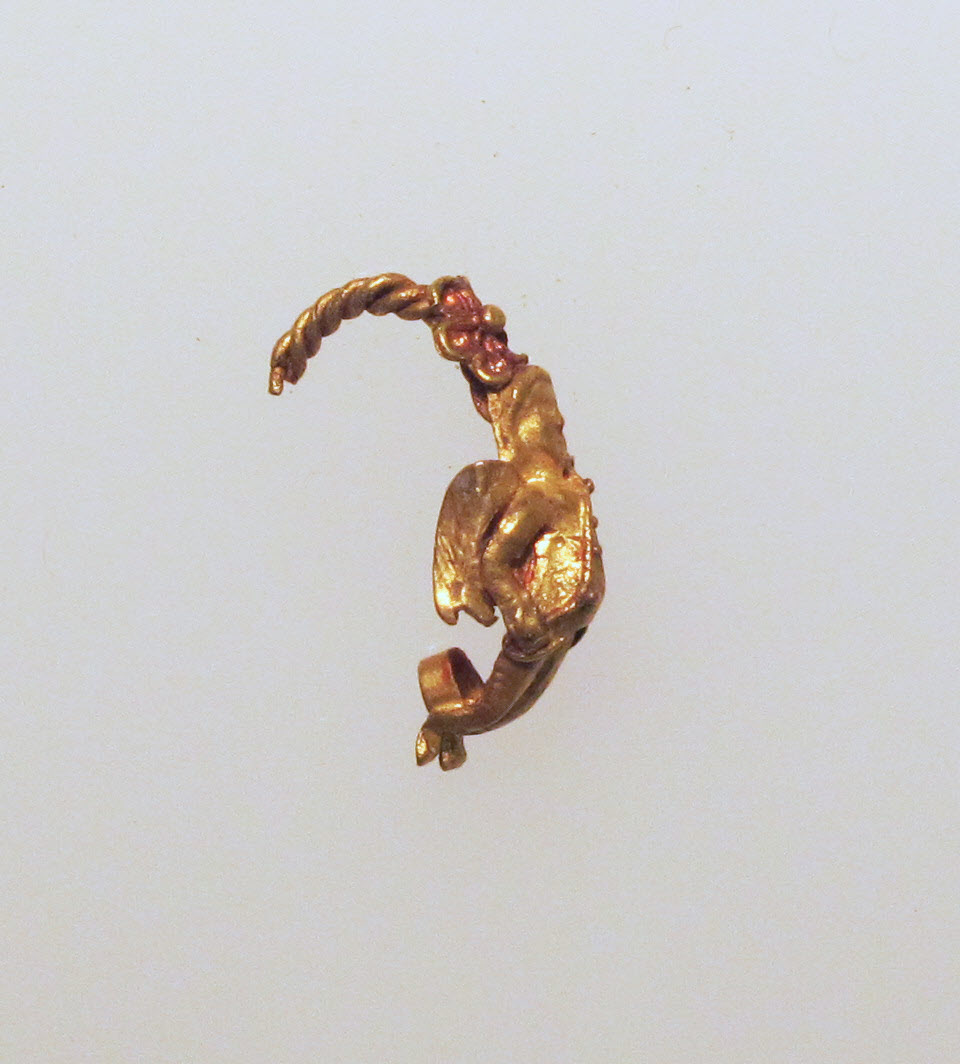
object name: earring with eros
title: Gold earring with winged Eros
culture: greek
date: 300-101 BCE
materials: gold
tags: eros